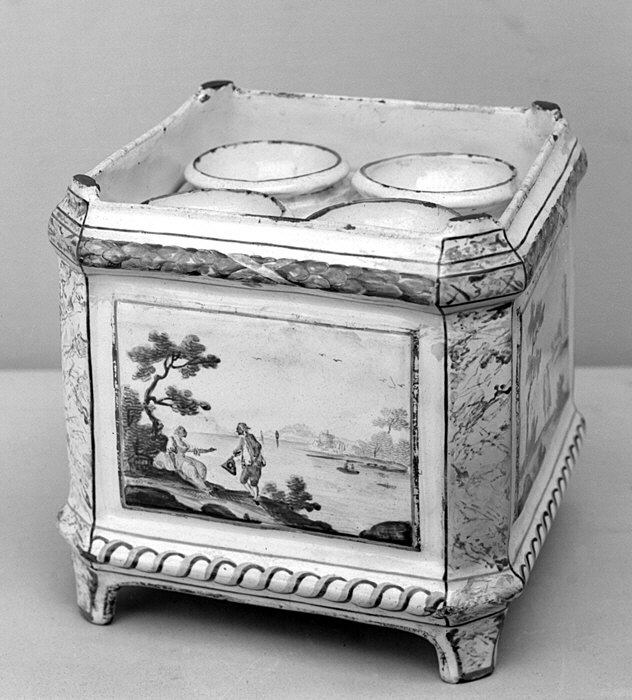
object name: jardinière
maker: fidelle duvivier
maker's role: decorator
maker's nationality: french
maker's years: 1740-1796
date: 1753-1795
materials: faience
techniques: glazing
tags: men,women,trees